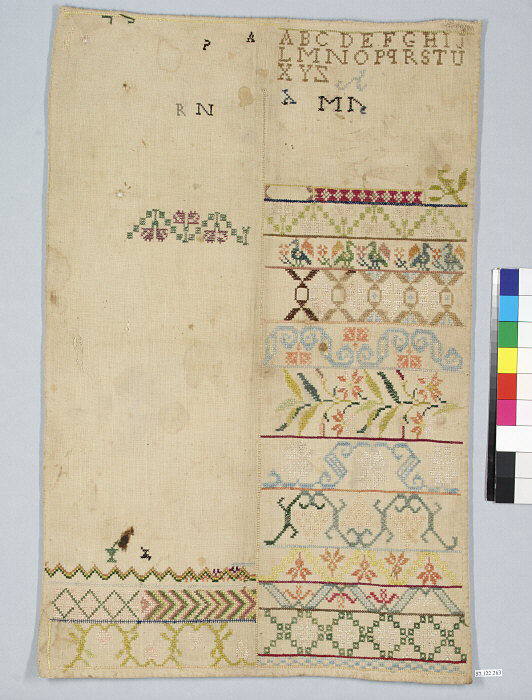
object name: sampler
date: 1801-1900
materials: cotton, silk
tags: birds,flowers